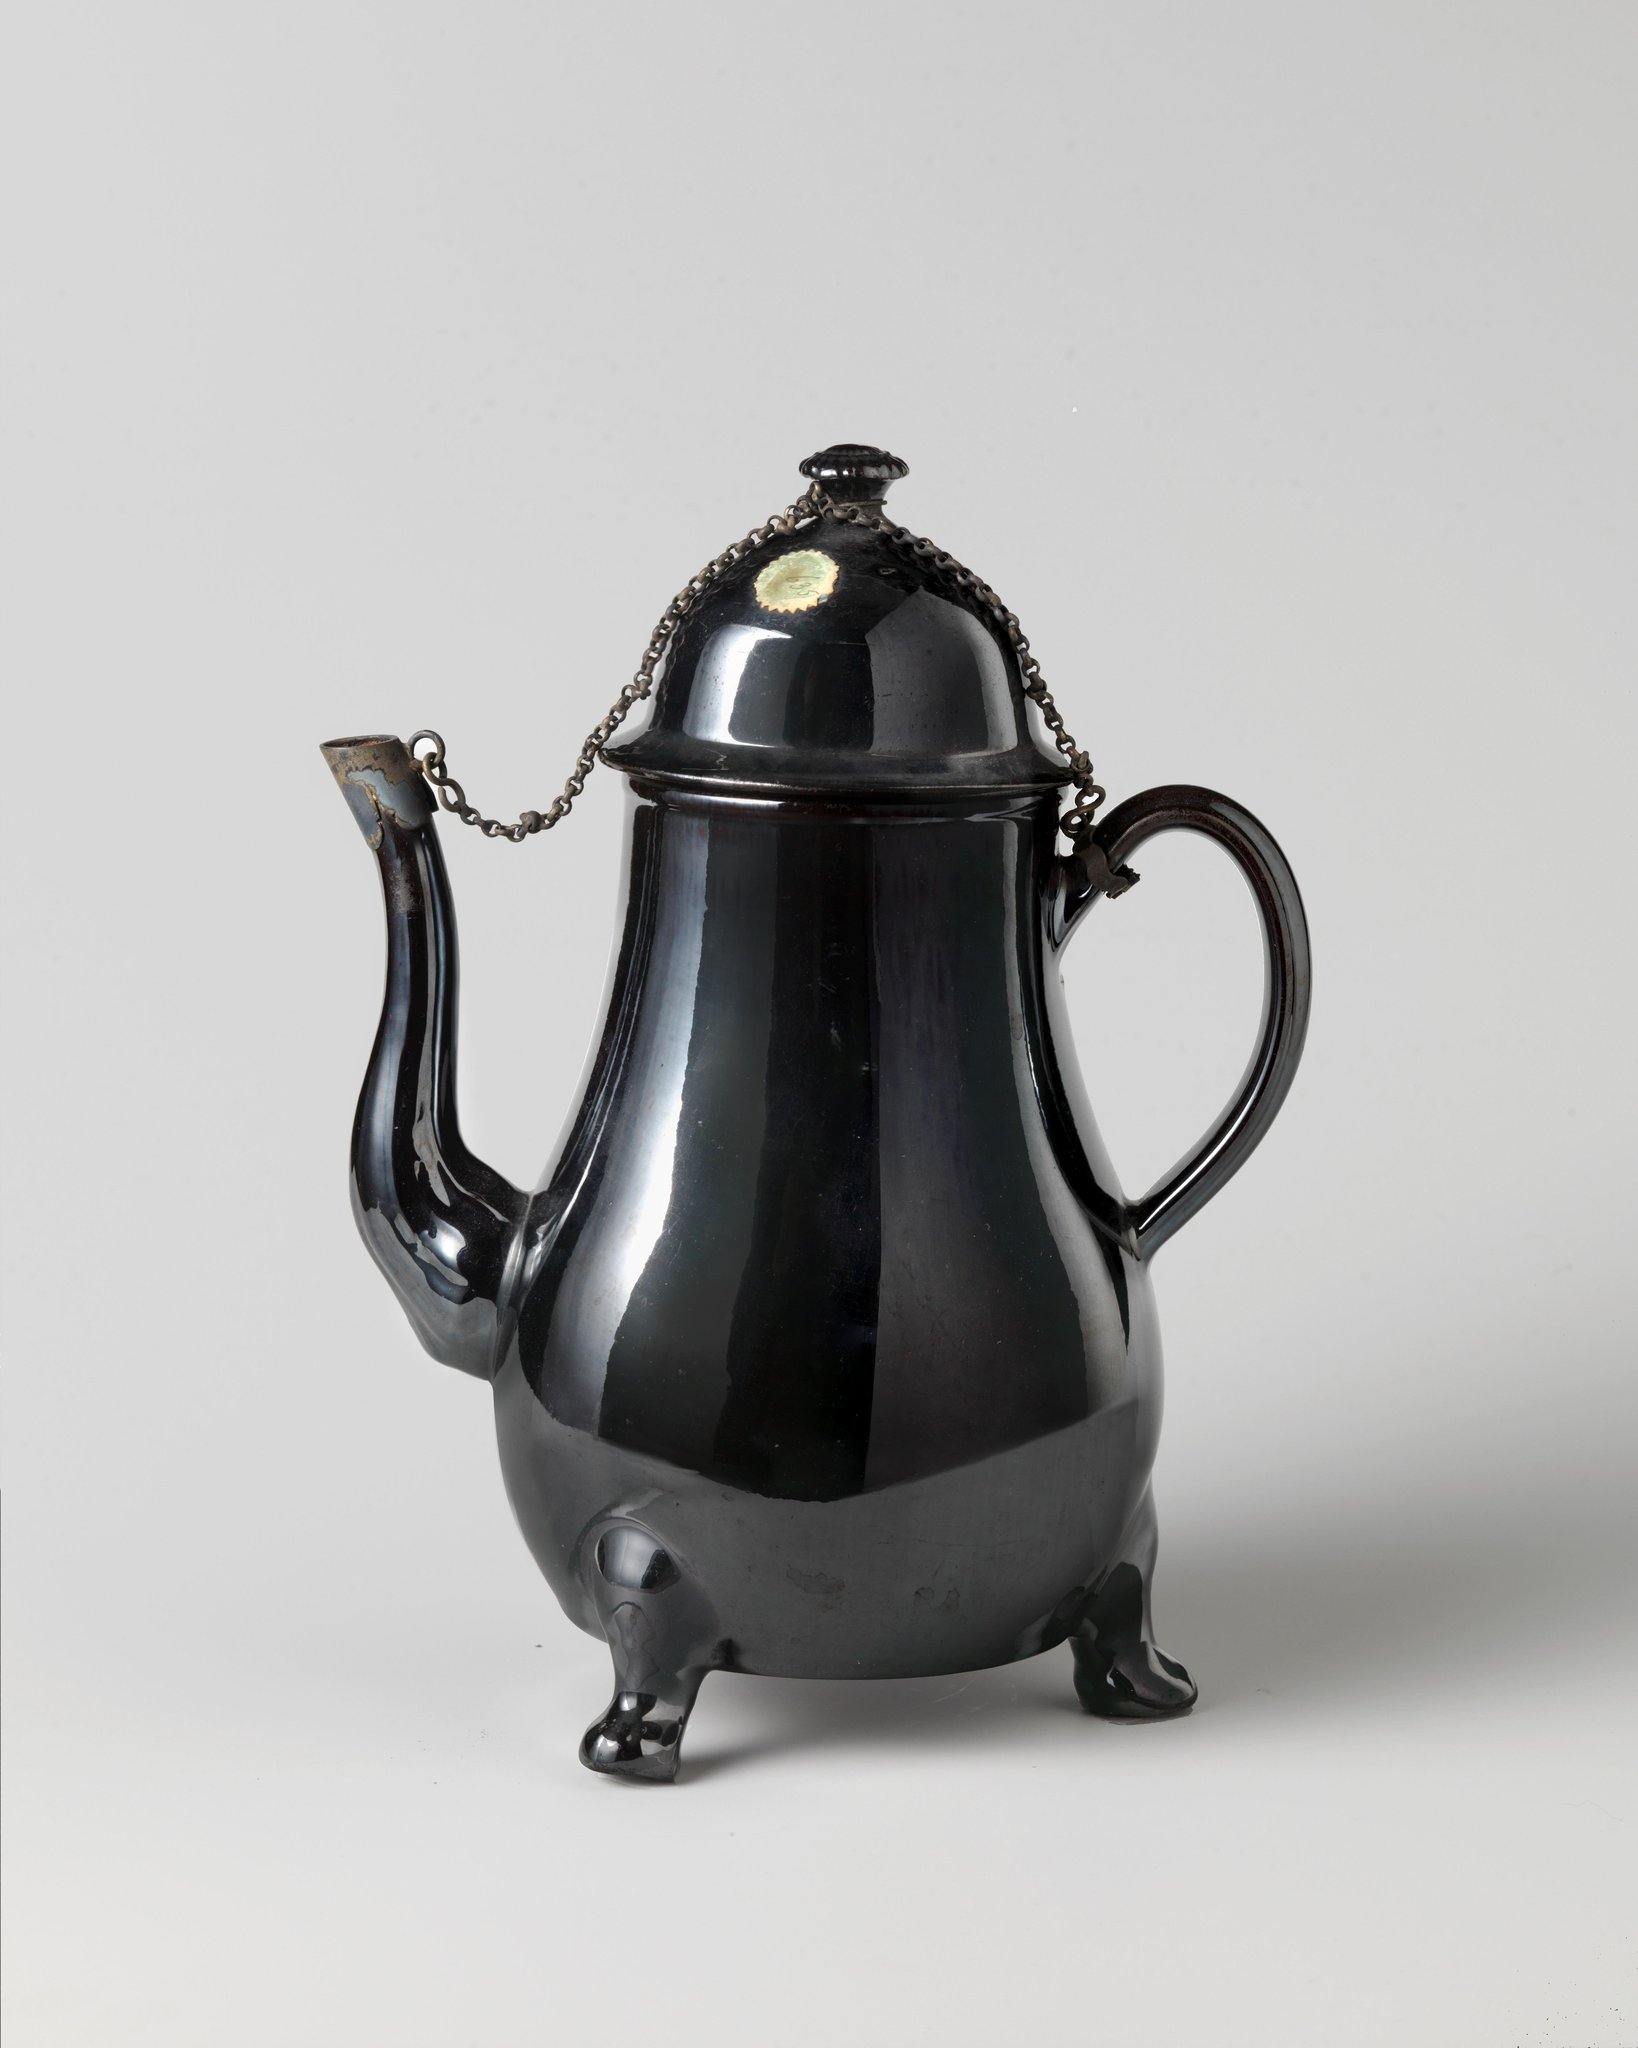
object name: coffee pot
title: Koffiekan met deksel van aardewerk met zwartdekkende glazuur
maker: Anonymous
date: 1740-1770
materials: earthenware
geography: jackfield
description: Peervormige koffiekan met deksel van aardewerk met zwartdekkende glazuur. De kan heeft een C-vormig oor, een S-vormige tuit en een hoog gewelfd deksel met een knop. De tuit heeft een montuur met een ketting. De ketting loopt van de tuit naar de knop van het deksel en vandaar naar het oor. De kan staat op drie kleine poten.